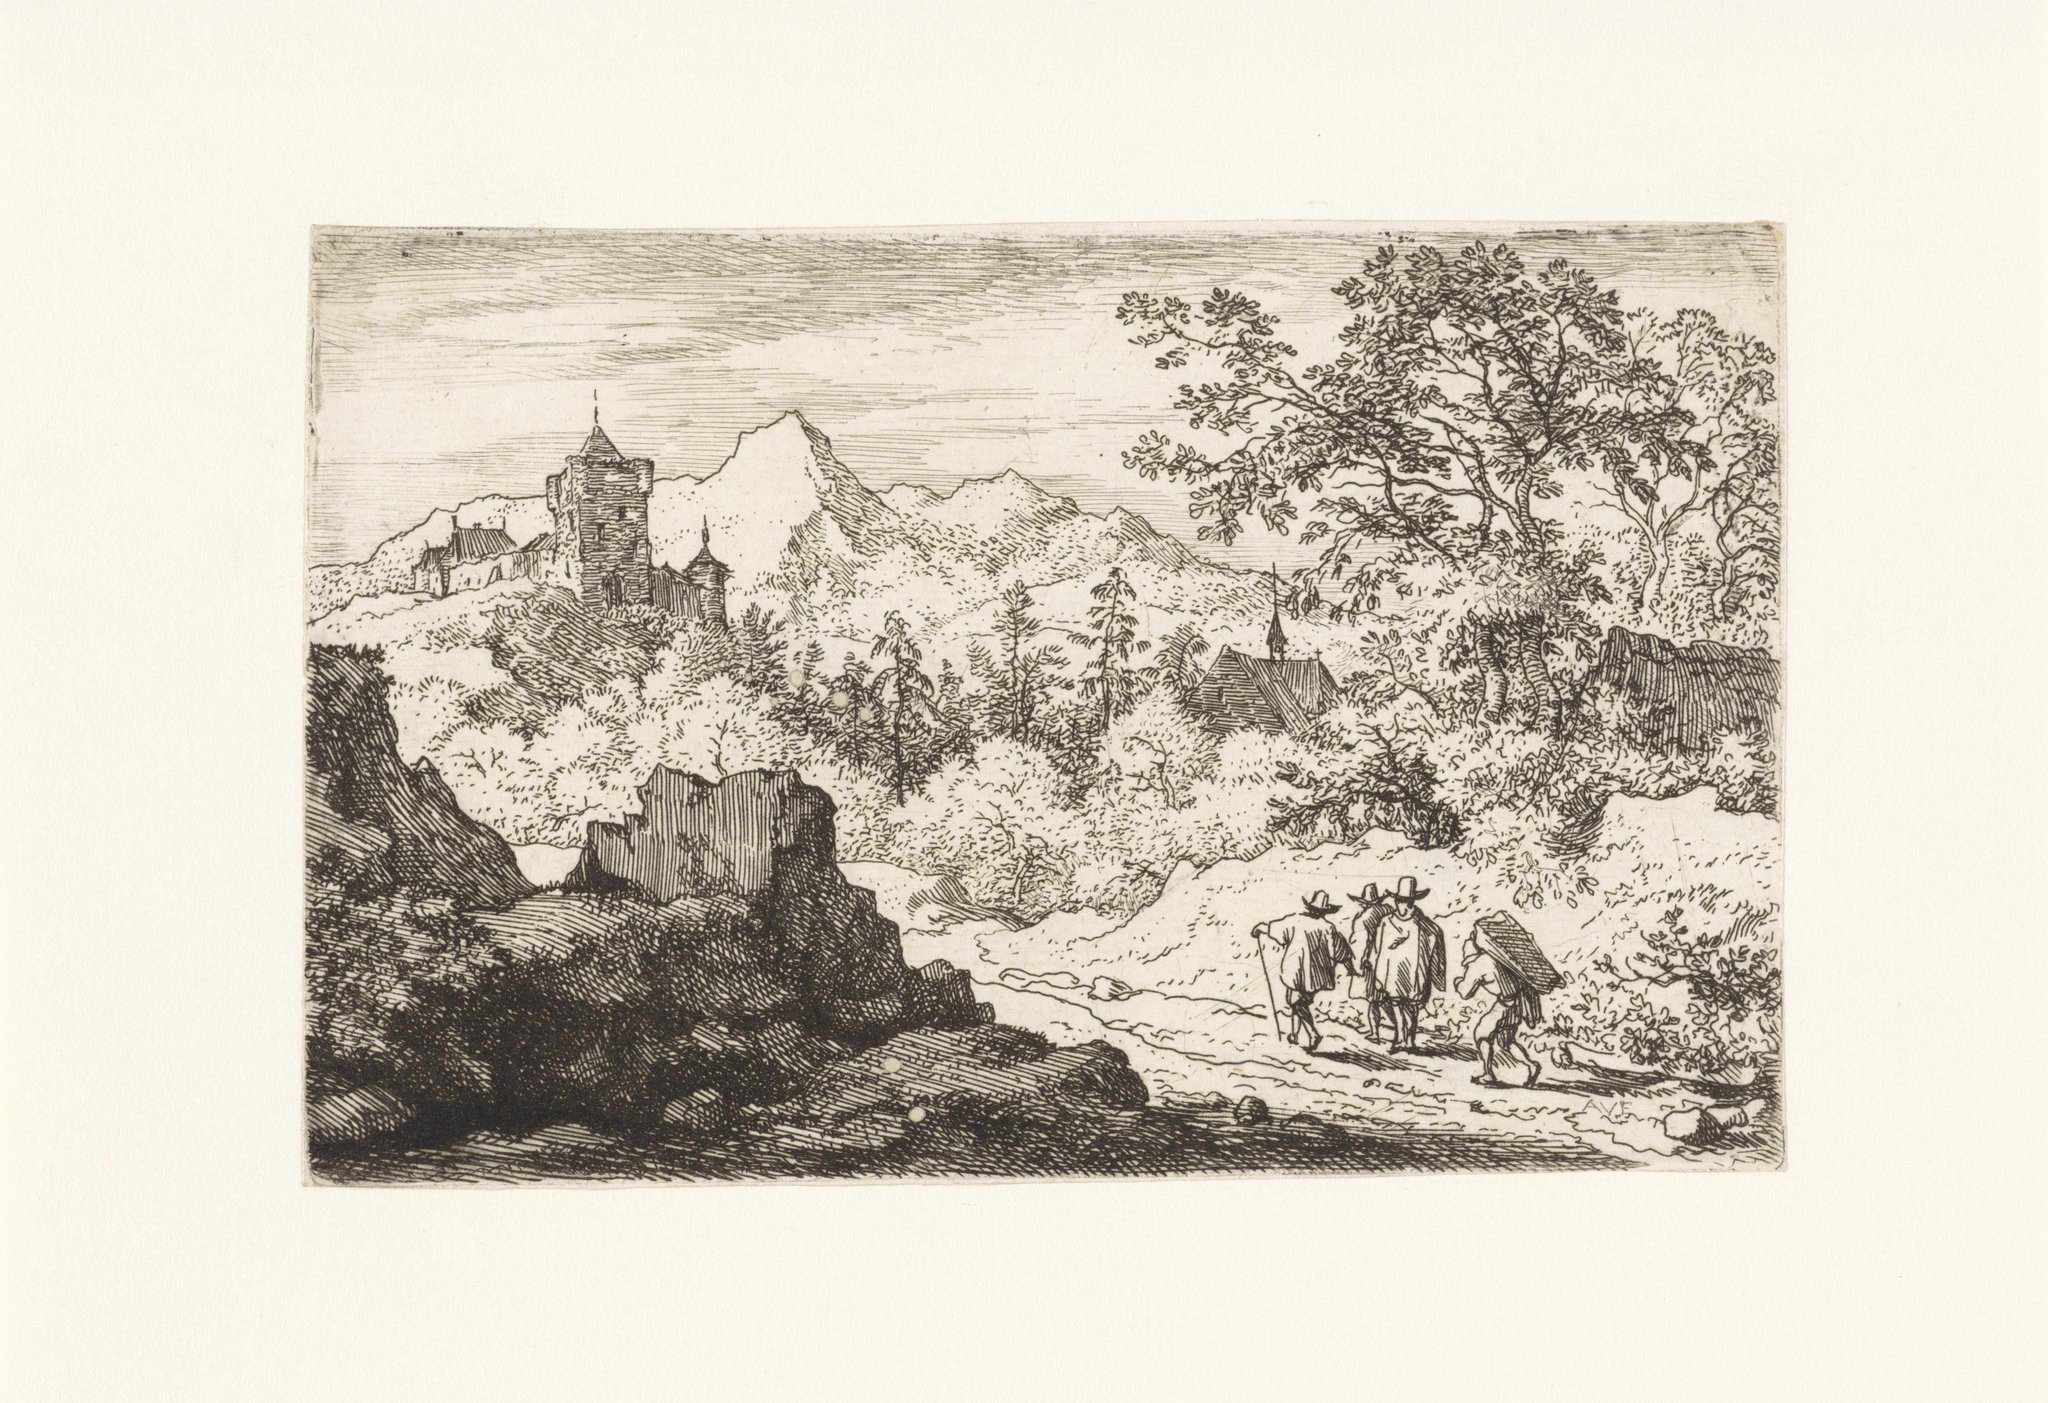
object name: print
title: Berglandschap met drie wandelaars en een kruier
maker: allaert van everdingen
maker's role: draughtsman, painter, print maker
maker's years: 1621-1675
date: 1631-1675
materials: paper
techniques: etching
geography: netherlands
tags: porter, bearer (+ three persons ~ traffic and transport)